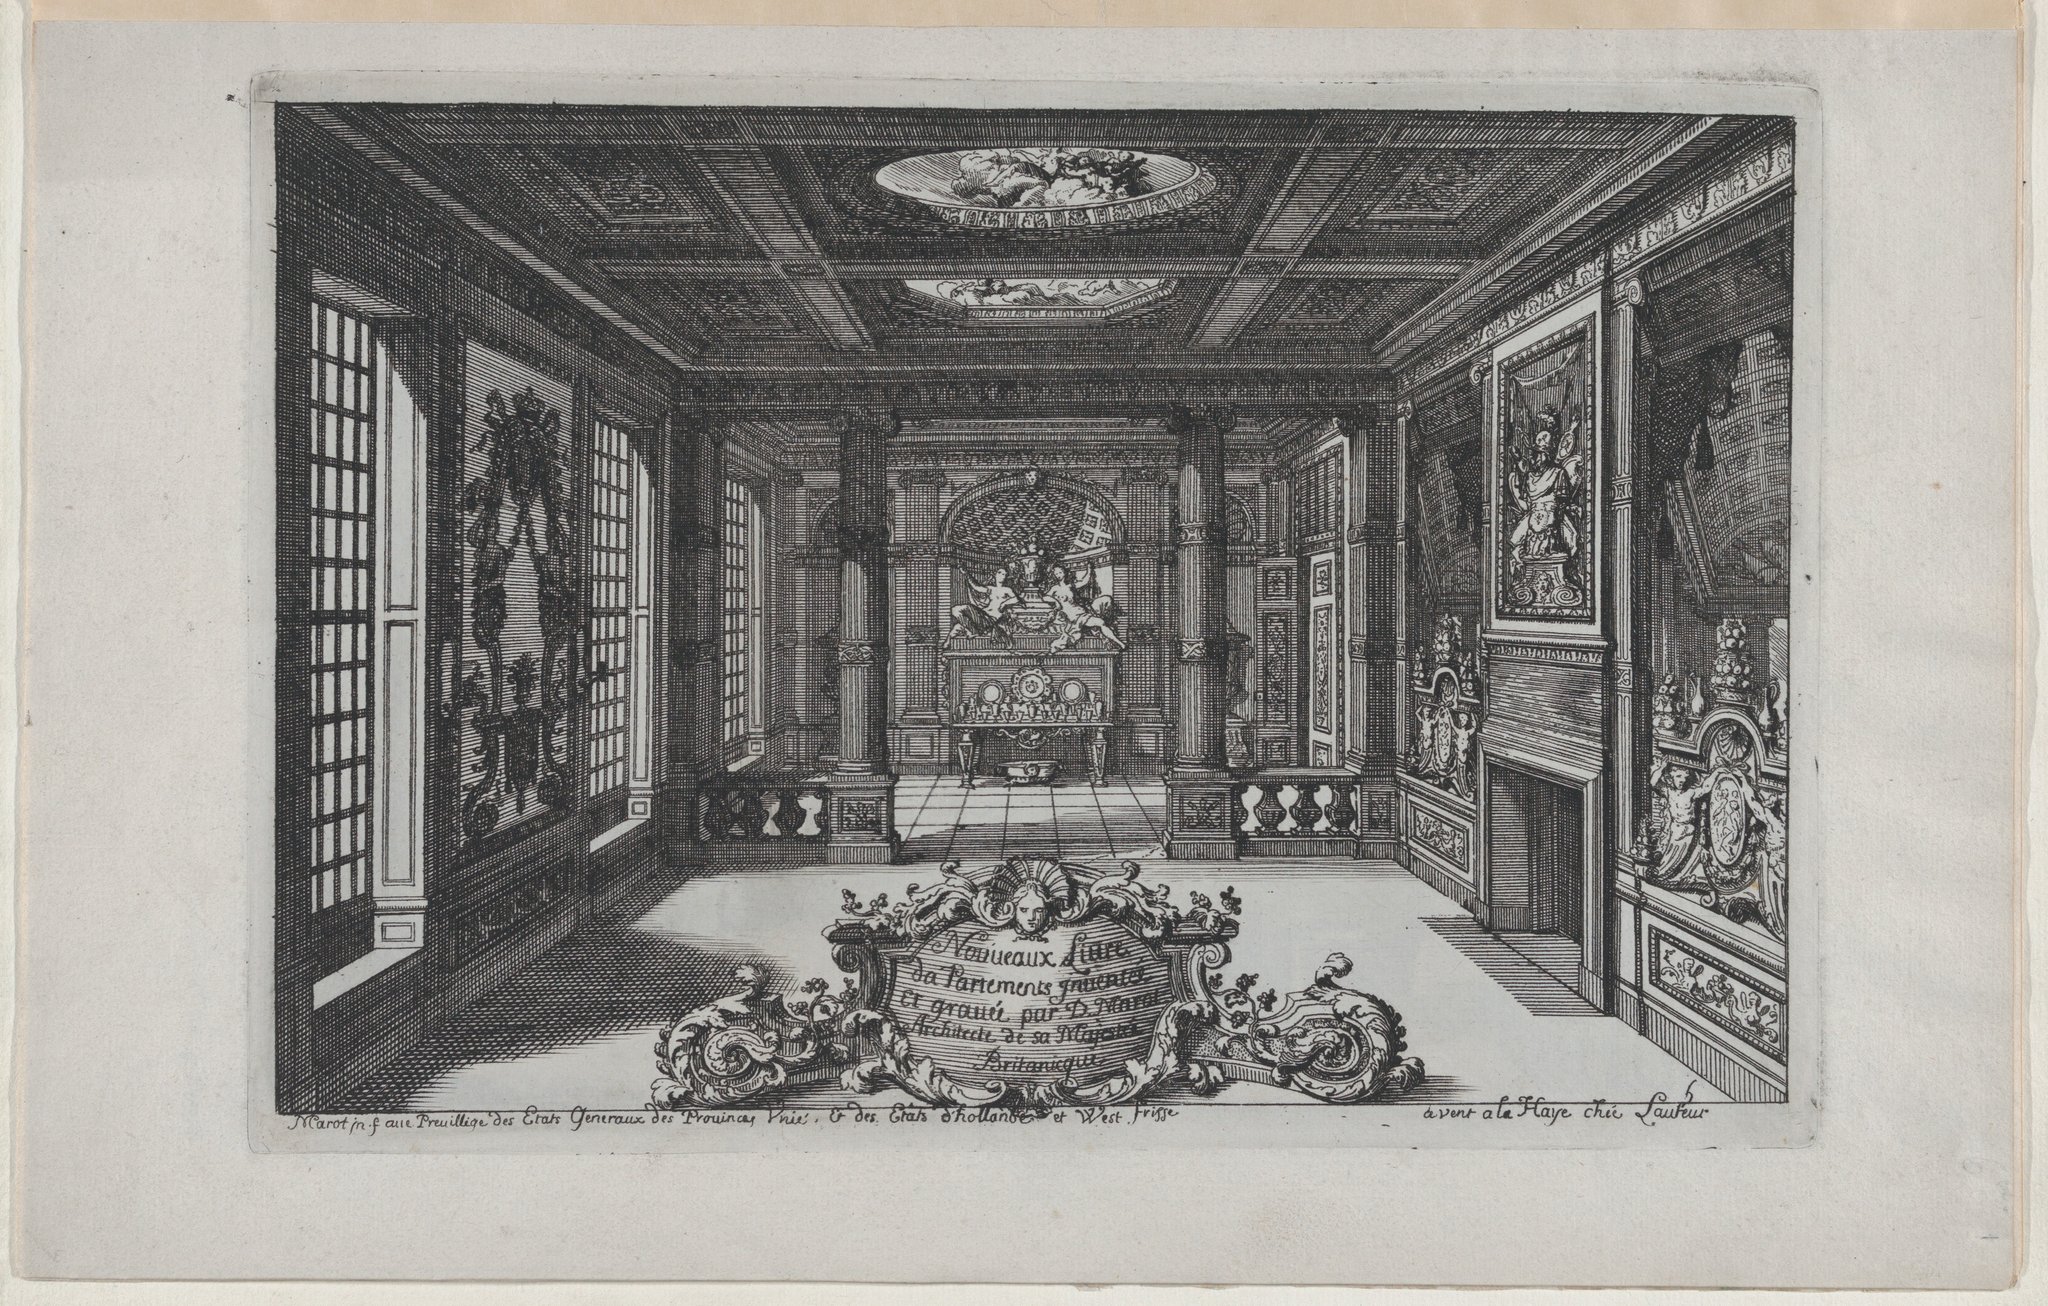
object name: print collection ornament architecture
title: Title Plate with a Cartouche Set in a Lavish Interior, from Nouveaux Liure da Partements, part of Œuvres du Sr. D. Marot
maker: daniel marot the elder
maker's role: artist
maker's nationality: french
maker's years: 1661-1752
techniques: etching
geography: netherlands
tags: interiors